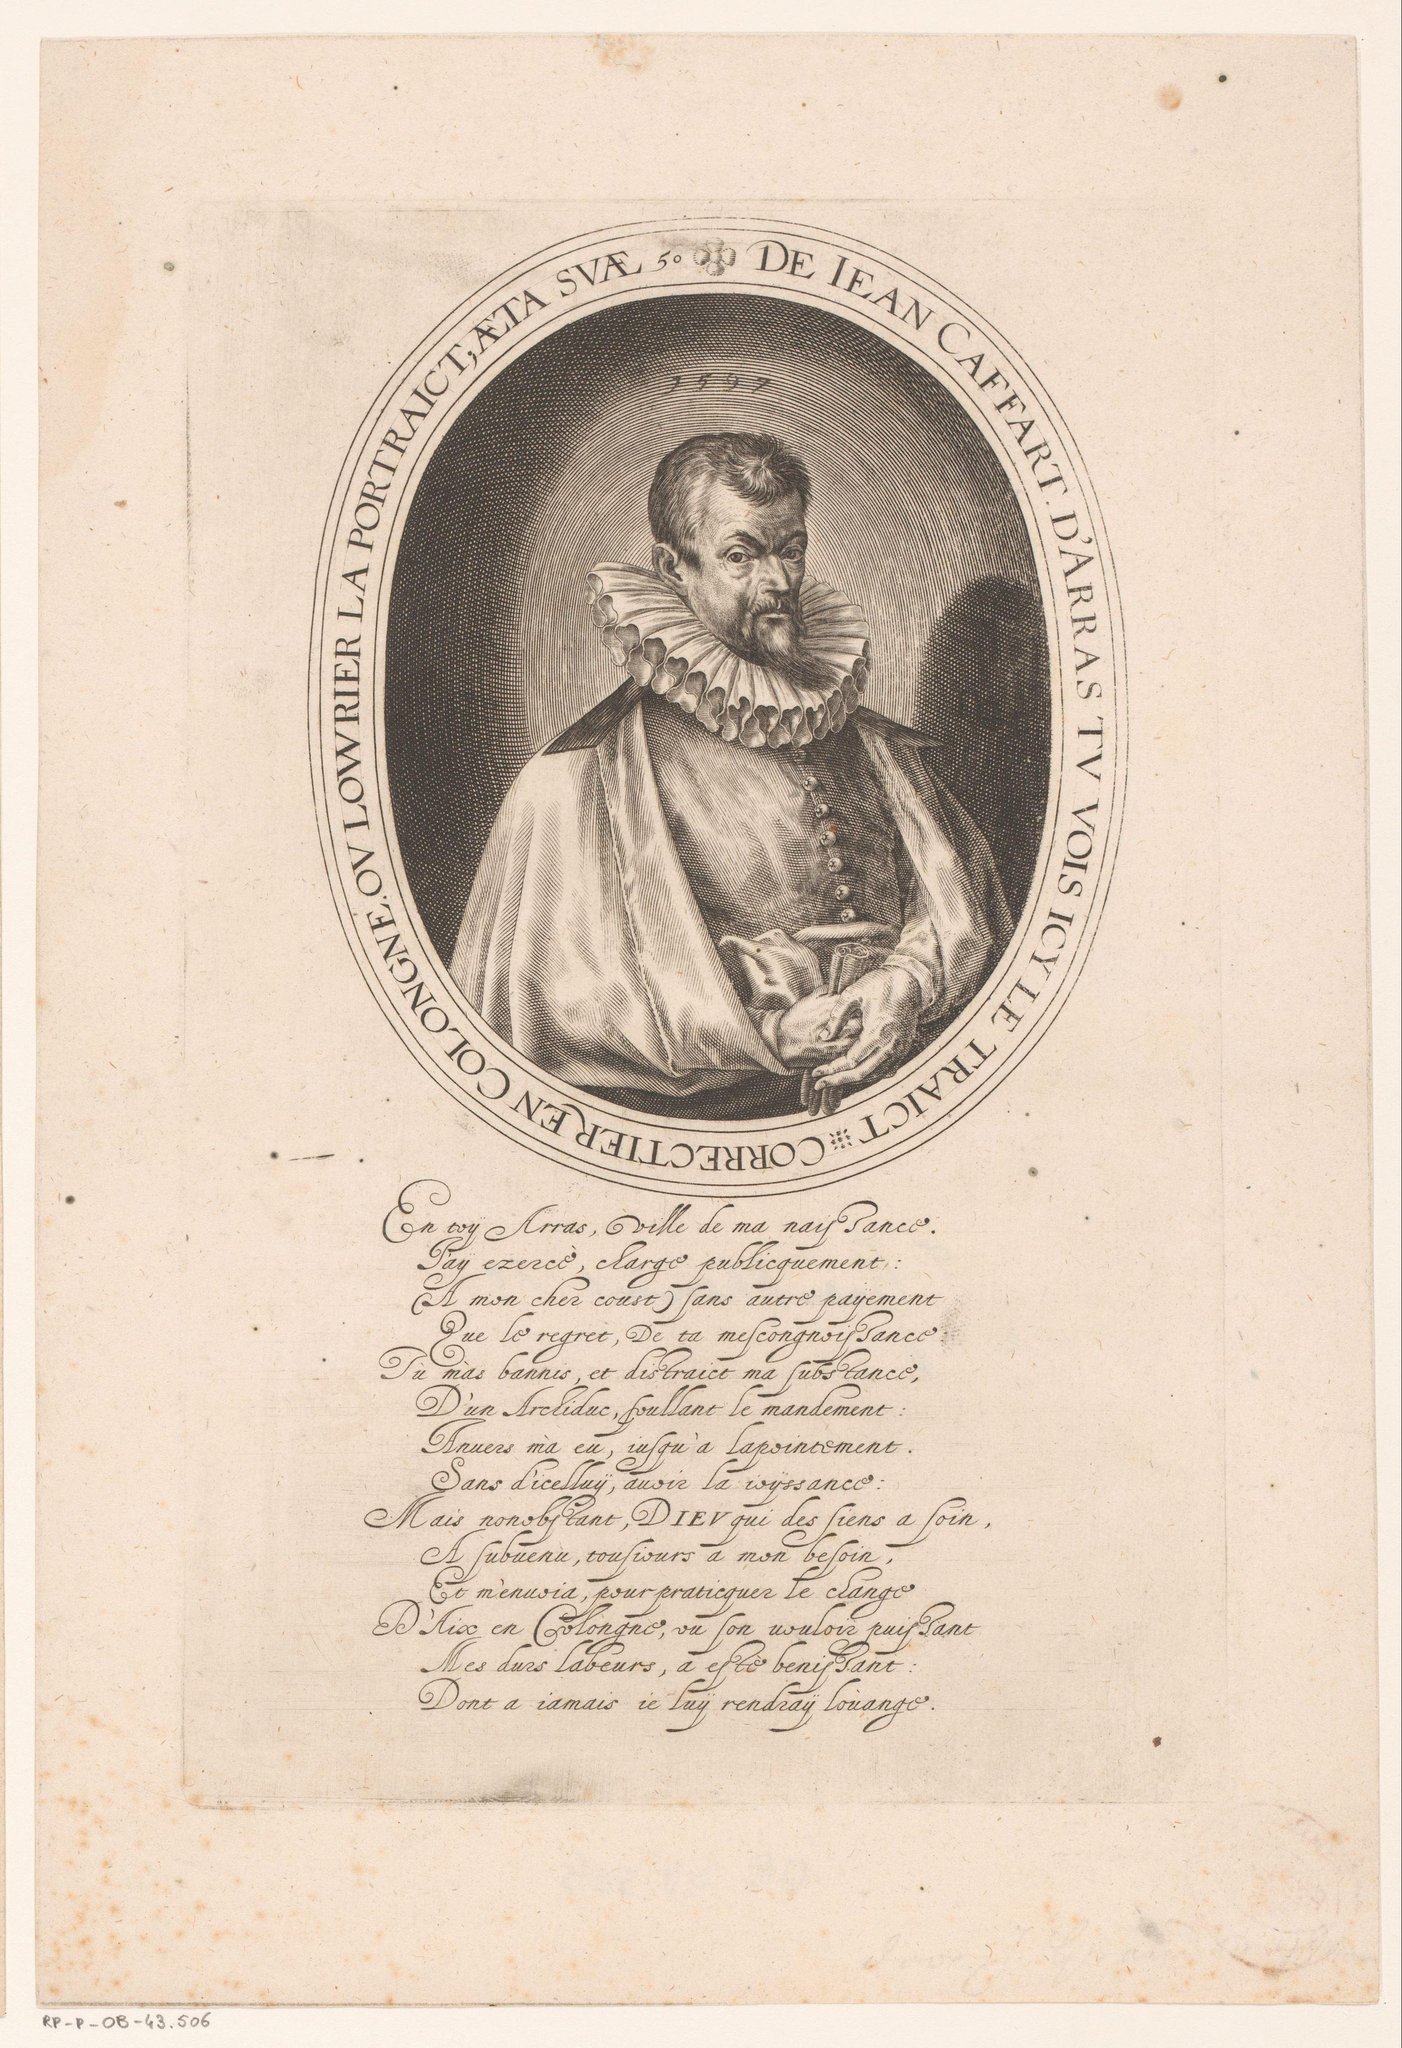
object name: print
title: Portret van Jean Caffart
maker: jacques granthomme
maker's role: print maker, publisher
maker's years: 1550-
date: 1597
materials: paper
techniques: engraving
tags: historical persons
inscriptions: collector's mark: Lugt 240